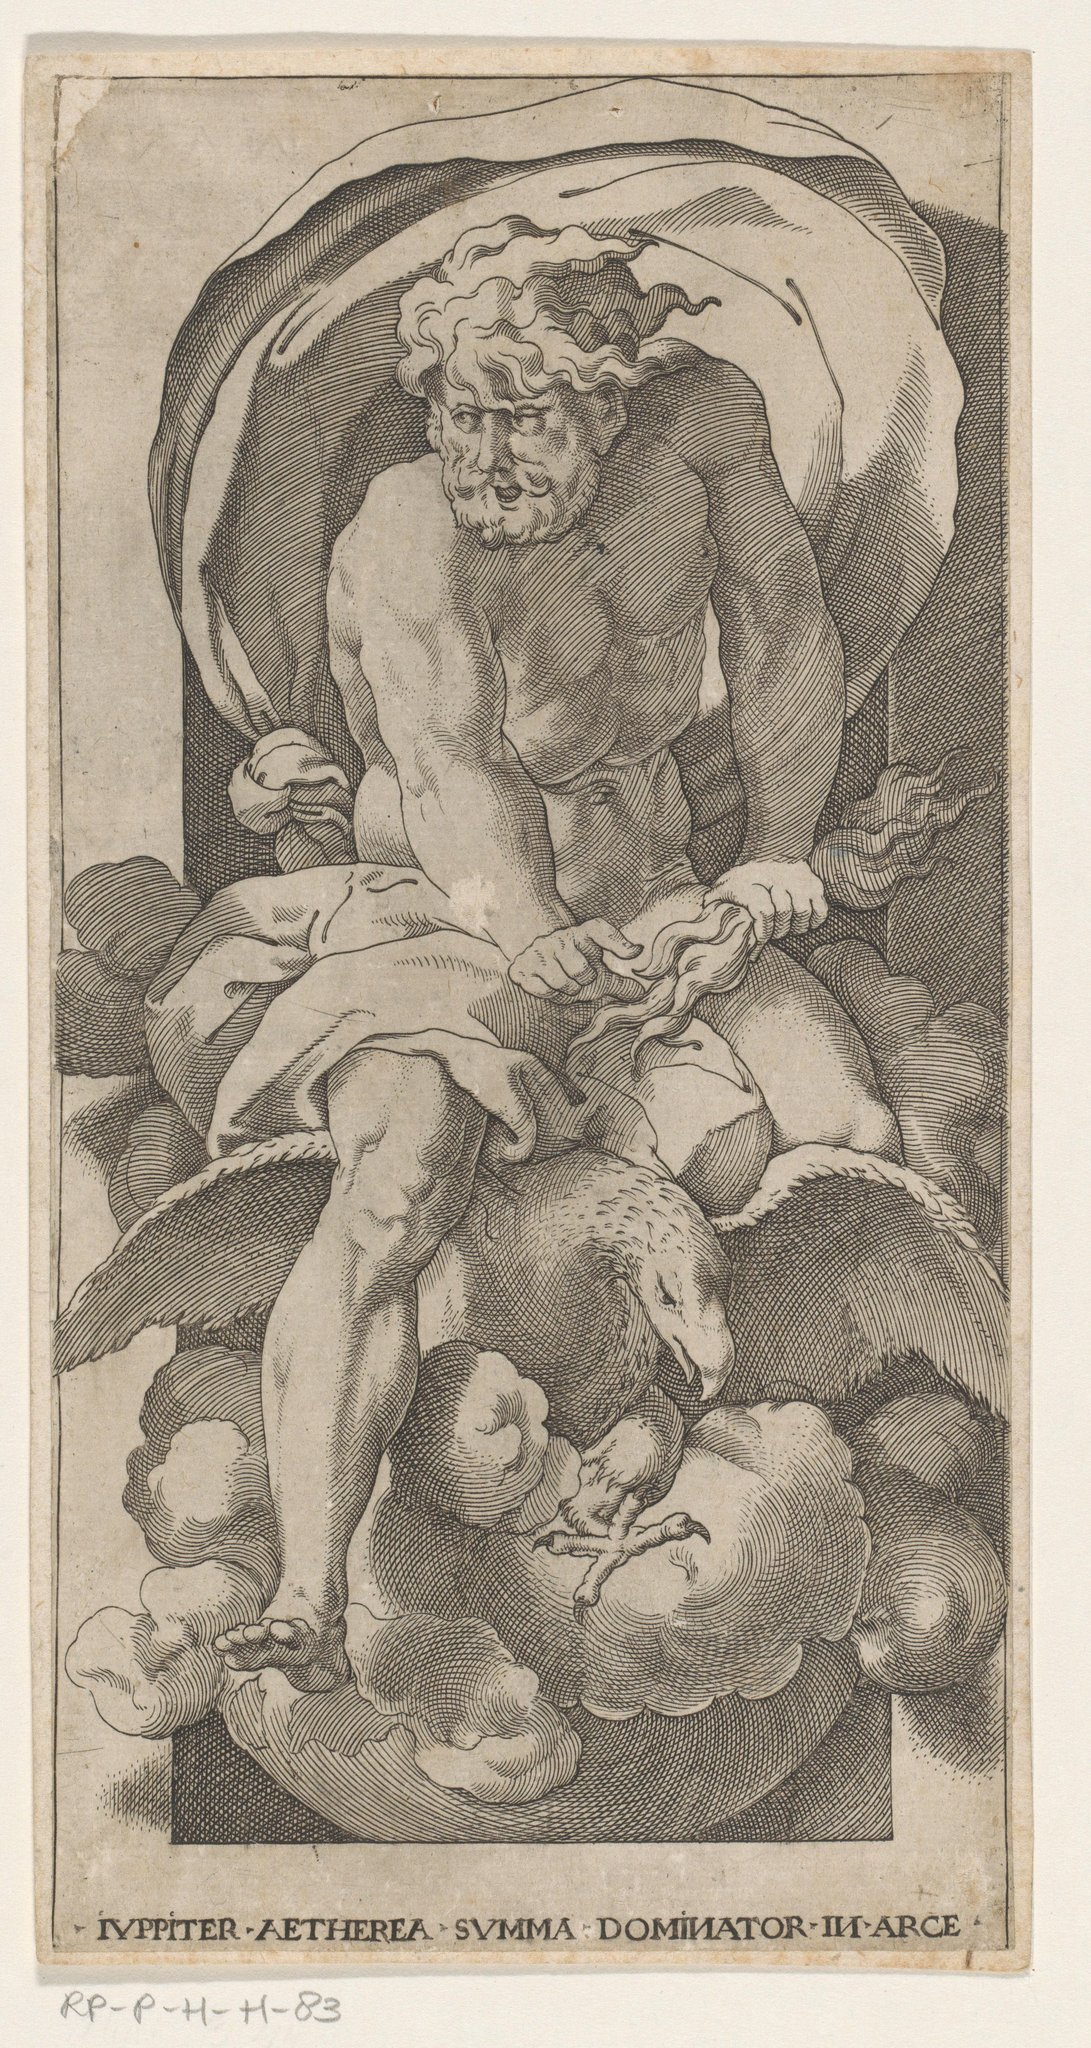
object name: print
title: Goden in nissen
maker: jacob binck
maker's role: painter, print maker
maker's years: 1494-1569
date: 1510-1569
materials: paper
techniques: engraving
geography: italy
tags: (story of) jupiter (zeus), attributes of jupiter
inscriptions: collector's mark: Lugt 11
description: De god Jupiter zit op een adelaar en met bliksemschichten in zijn hand in een nis.